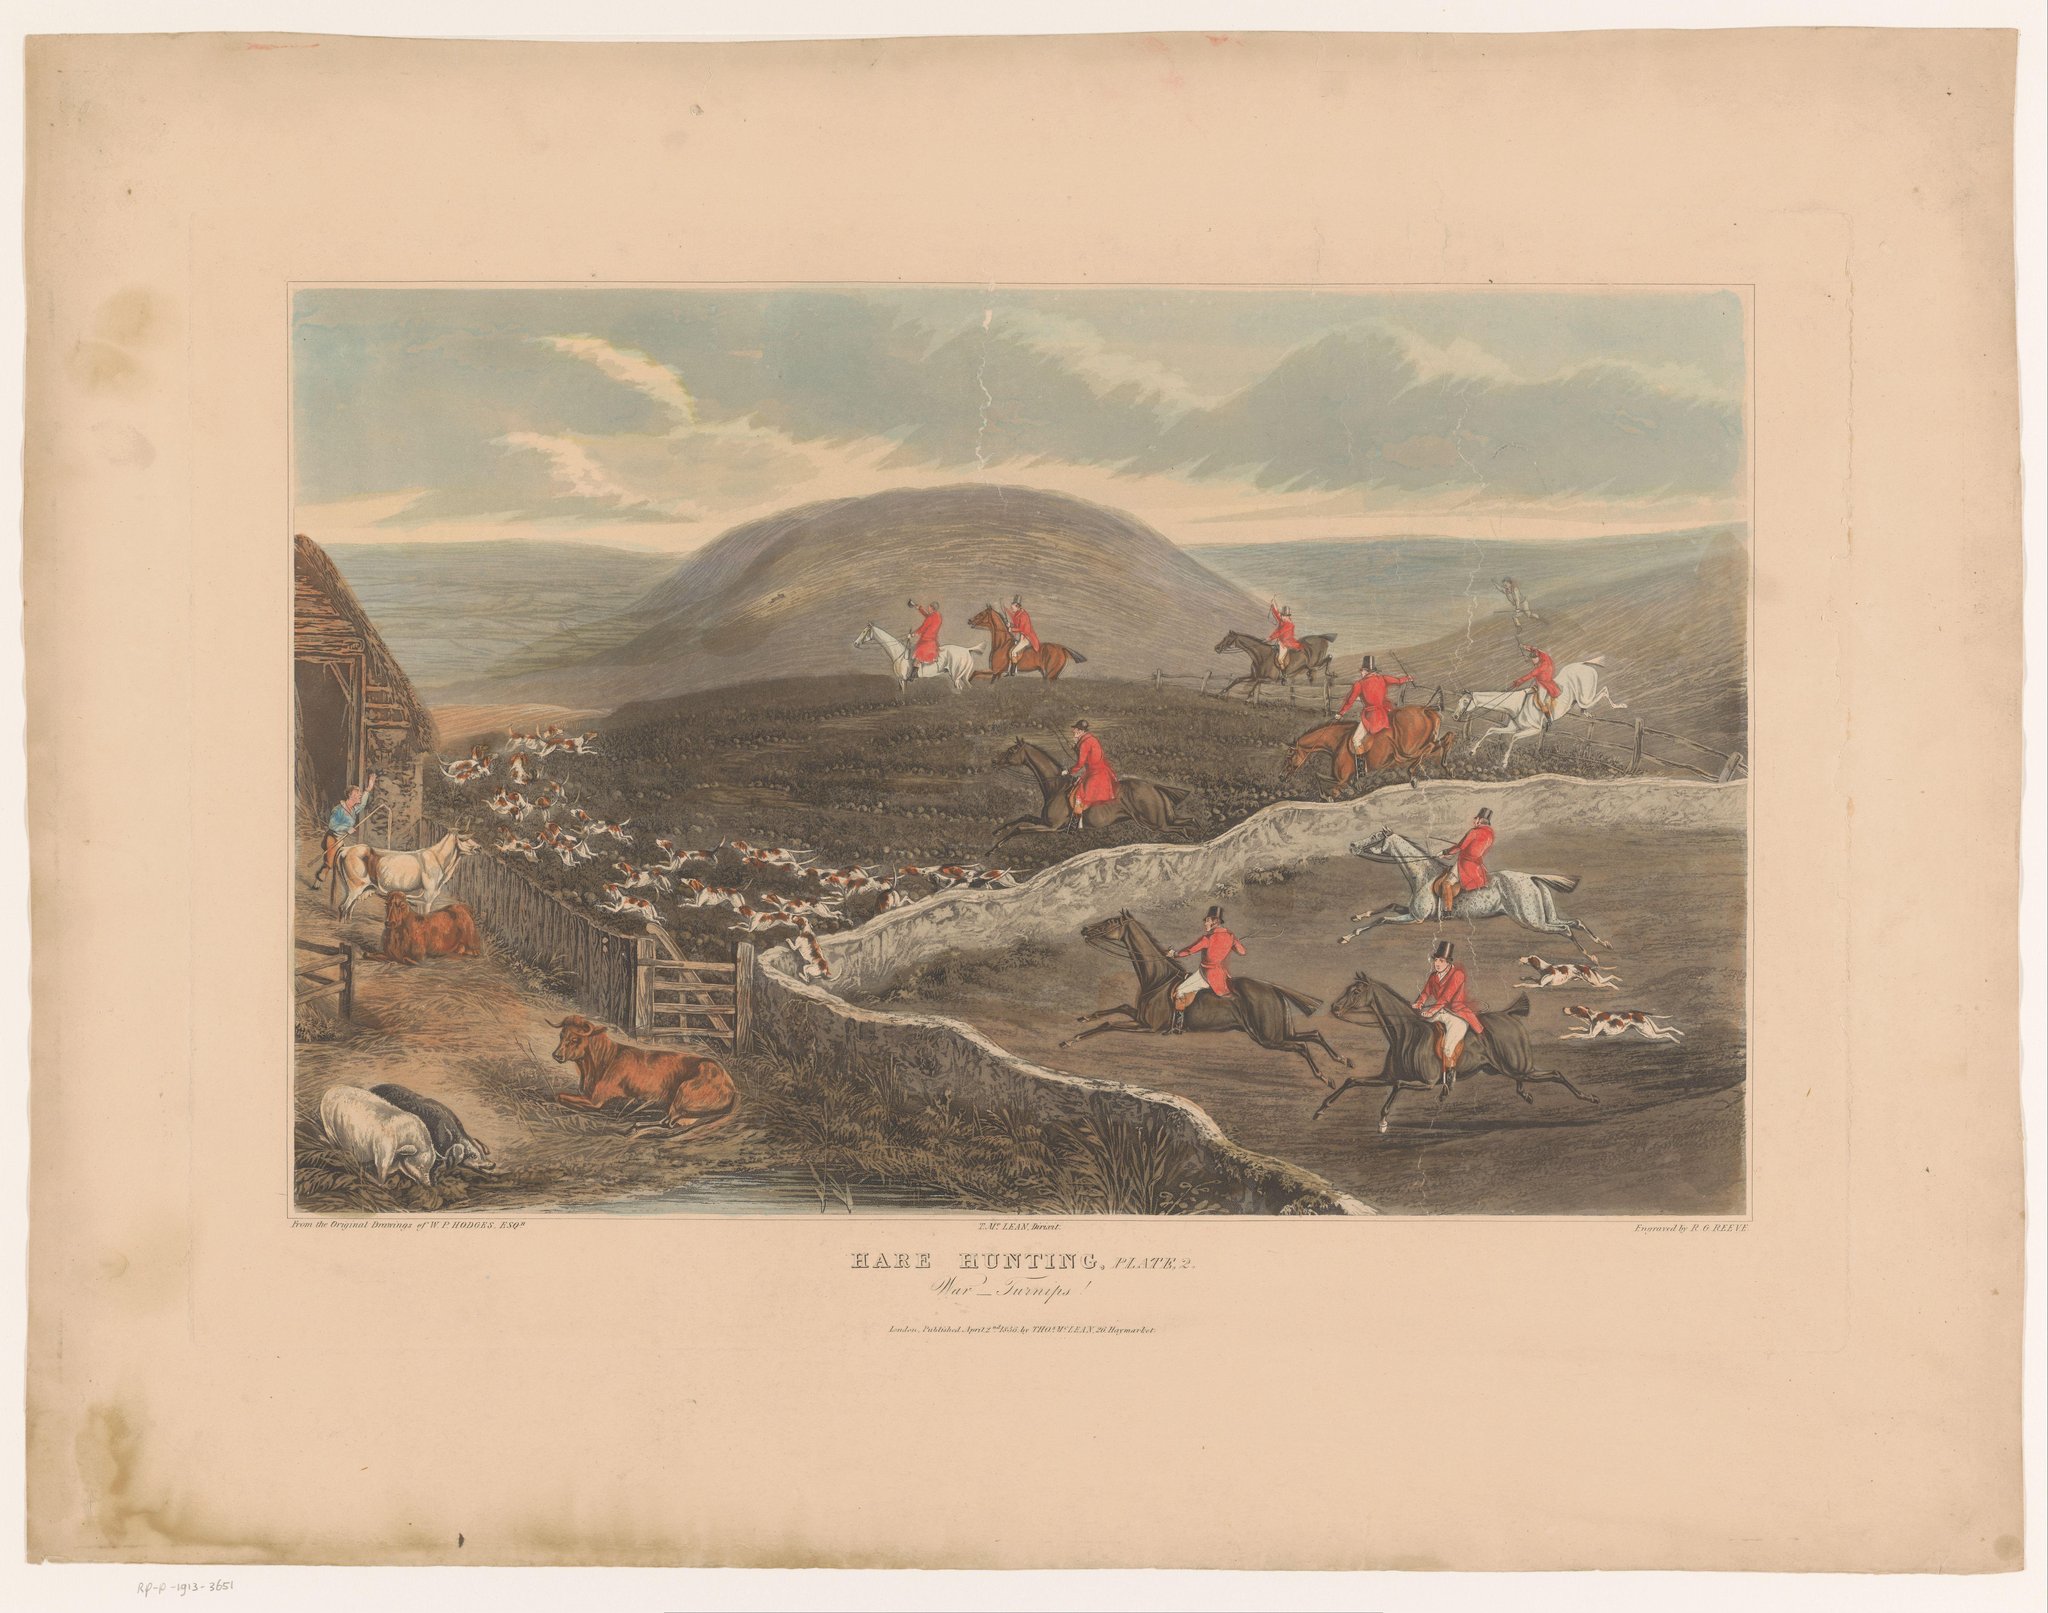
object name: print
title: Hare Hunting, Plate 2. War Turnips!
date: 1804-1836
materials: paper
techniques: aquatint, etching, hand coloring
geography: london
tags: riding a horse, ass, or mule; rider, horseman, low hill country, hunting dogs, hunters hunting (n.b.: in 1988-1990 this notation denoted the concept of 43c11421 'hunters resting during the hunt'), farmers, hare-hunting, rabbit-hunting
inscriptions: collector's mark: Lugt 2233